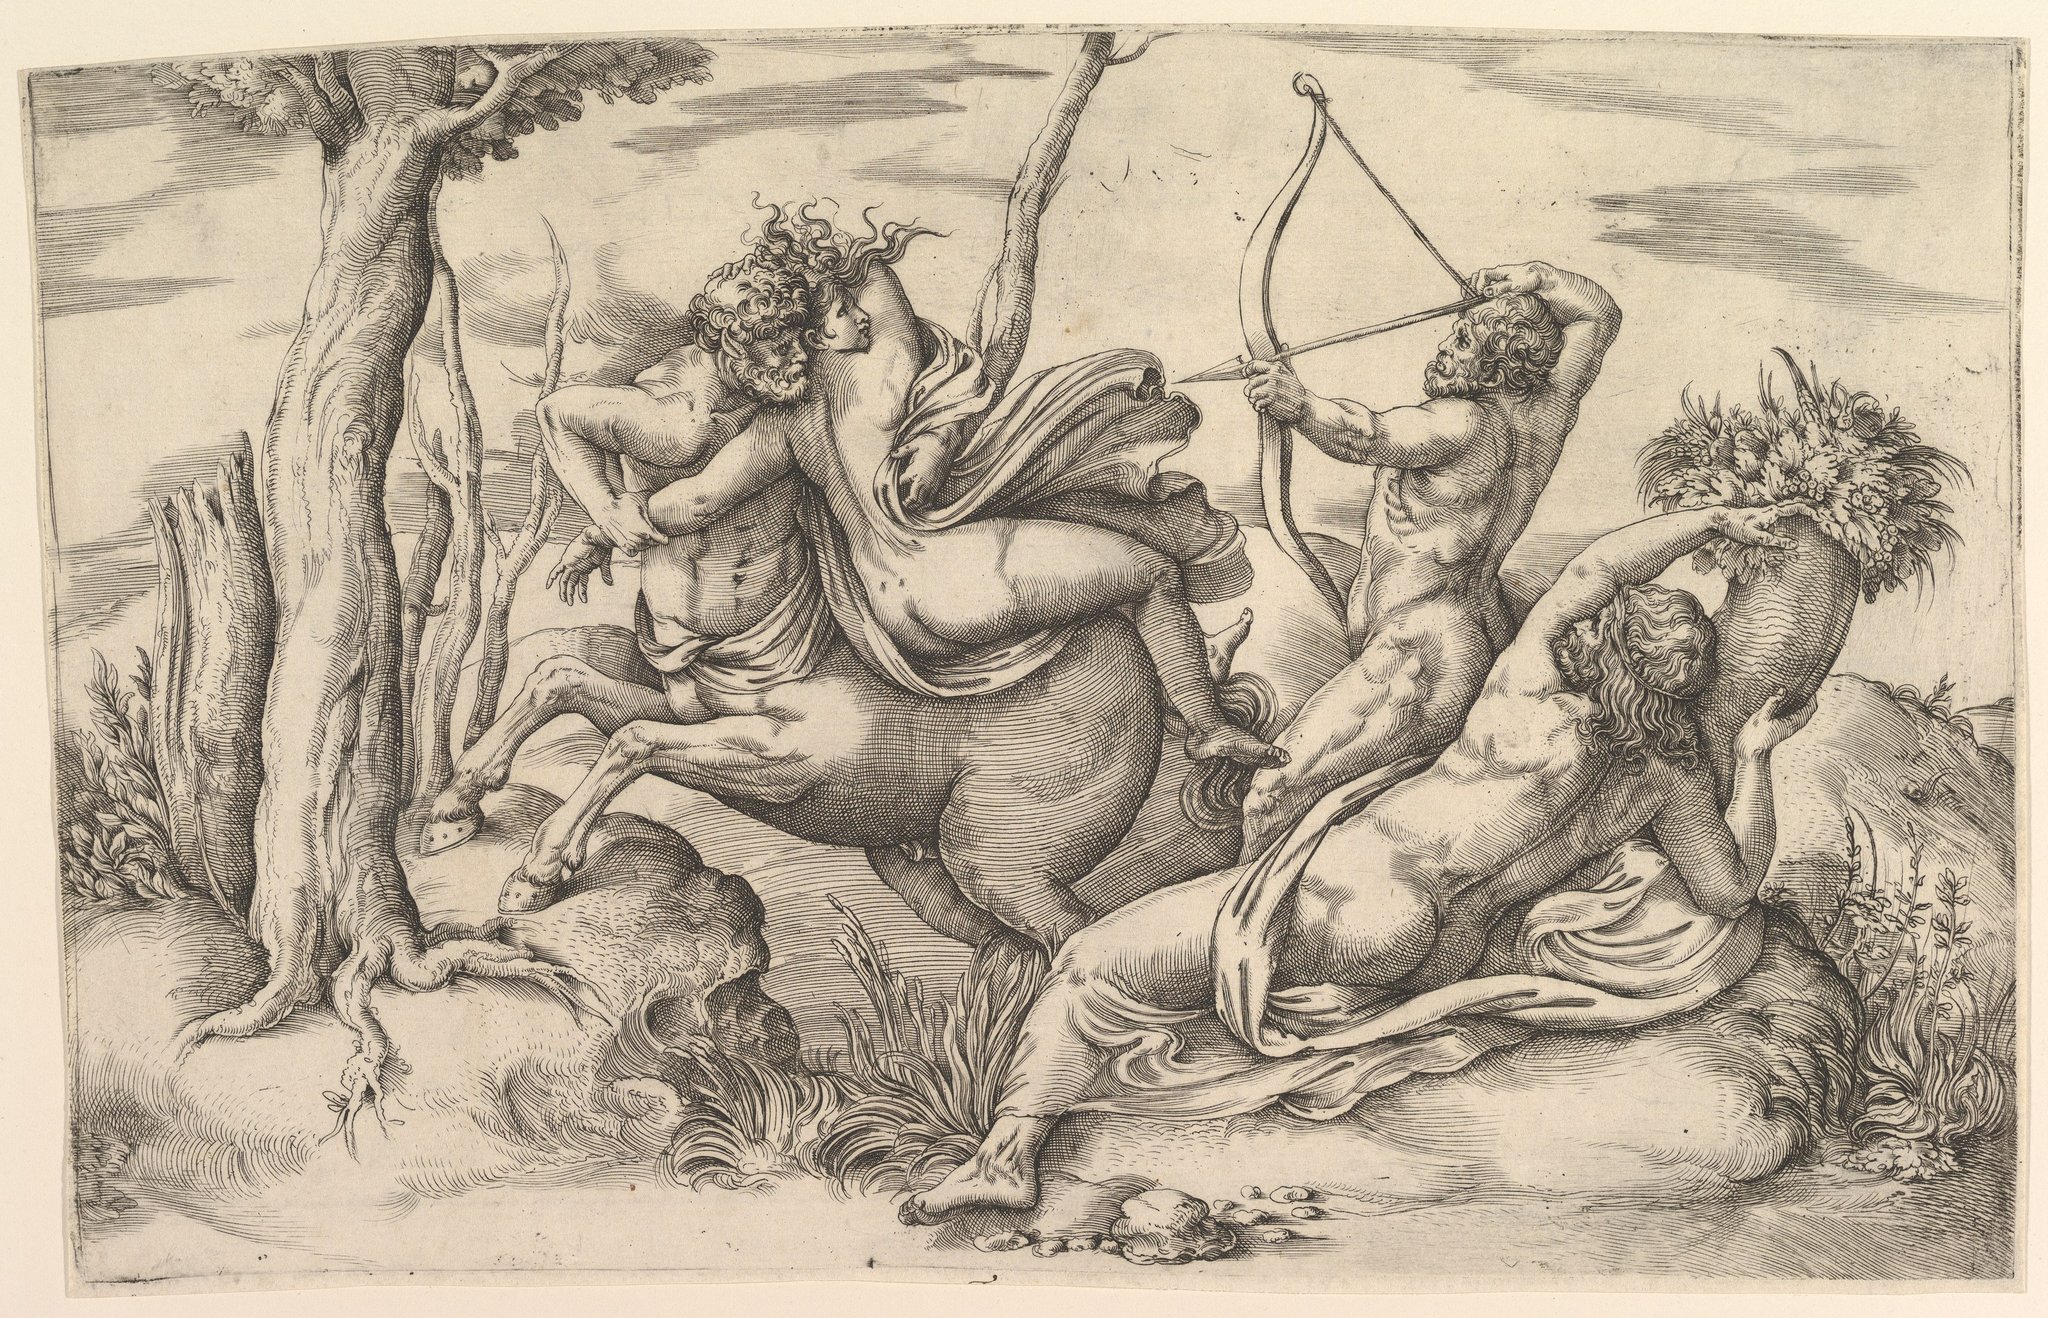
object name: print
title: The abduction of Dejanira held by the centaur Nessus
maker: battista franco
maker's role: artist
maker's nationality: italian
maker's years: 1510-1561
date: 1530-1561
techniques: engraving, etching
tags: bow and arrow,male nudes,female nudes,centaurs